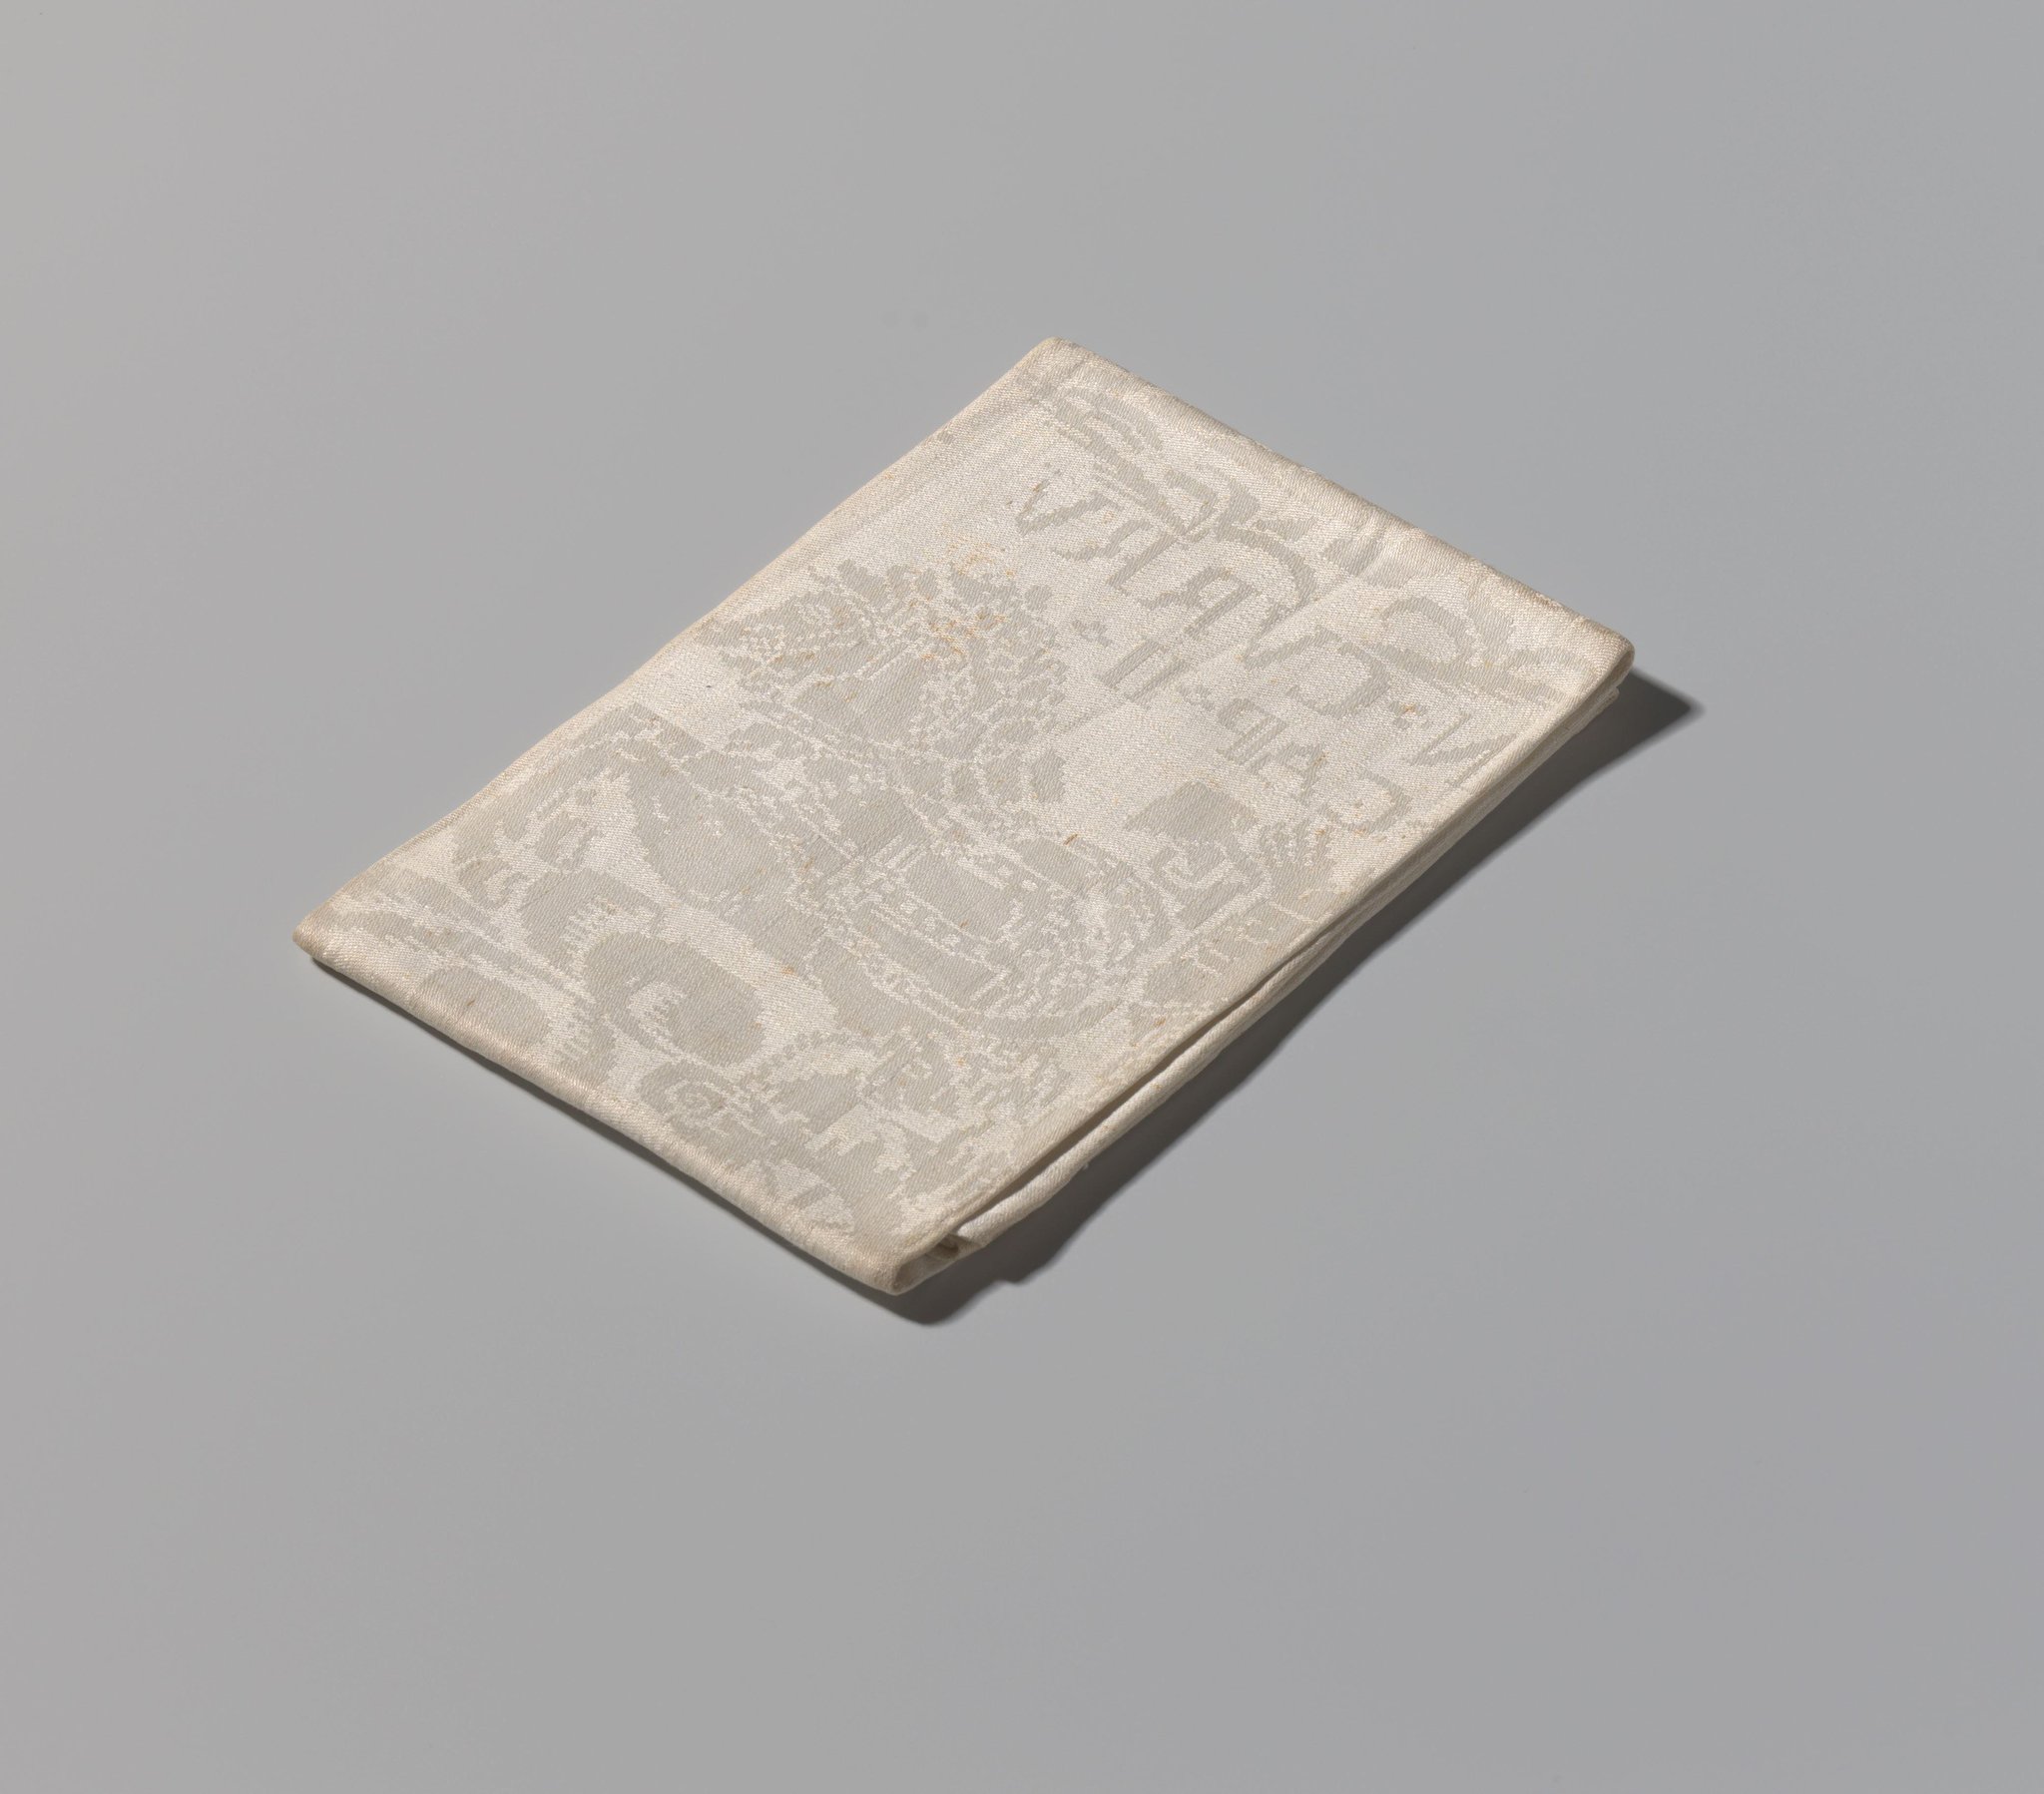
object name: napkin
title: Servet met de geschiedenis van de profeet Elia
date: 1600-1649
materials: linen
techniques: damask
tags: story of elijah (elias)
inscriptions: mark: ‘IVDH 6’